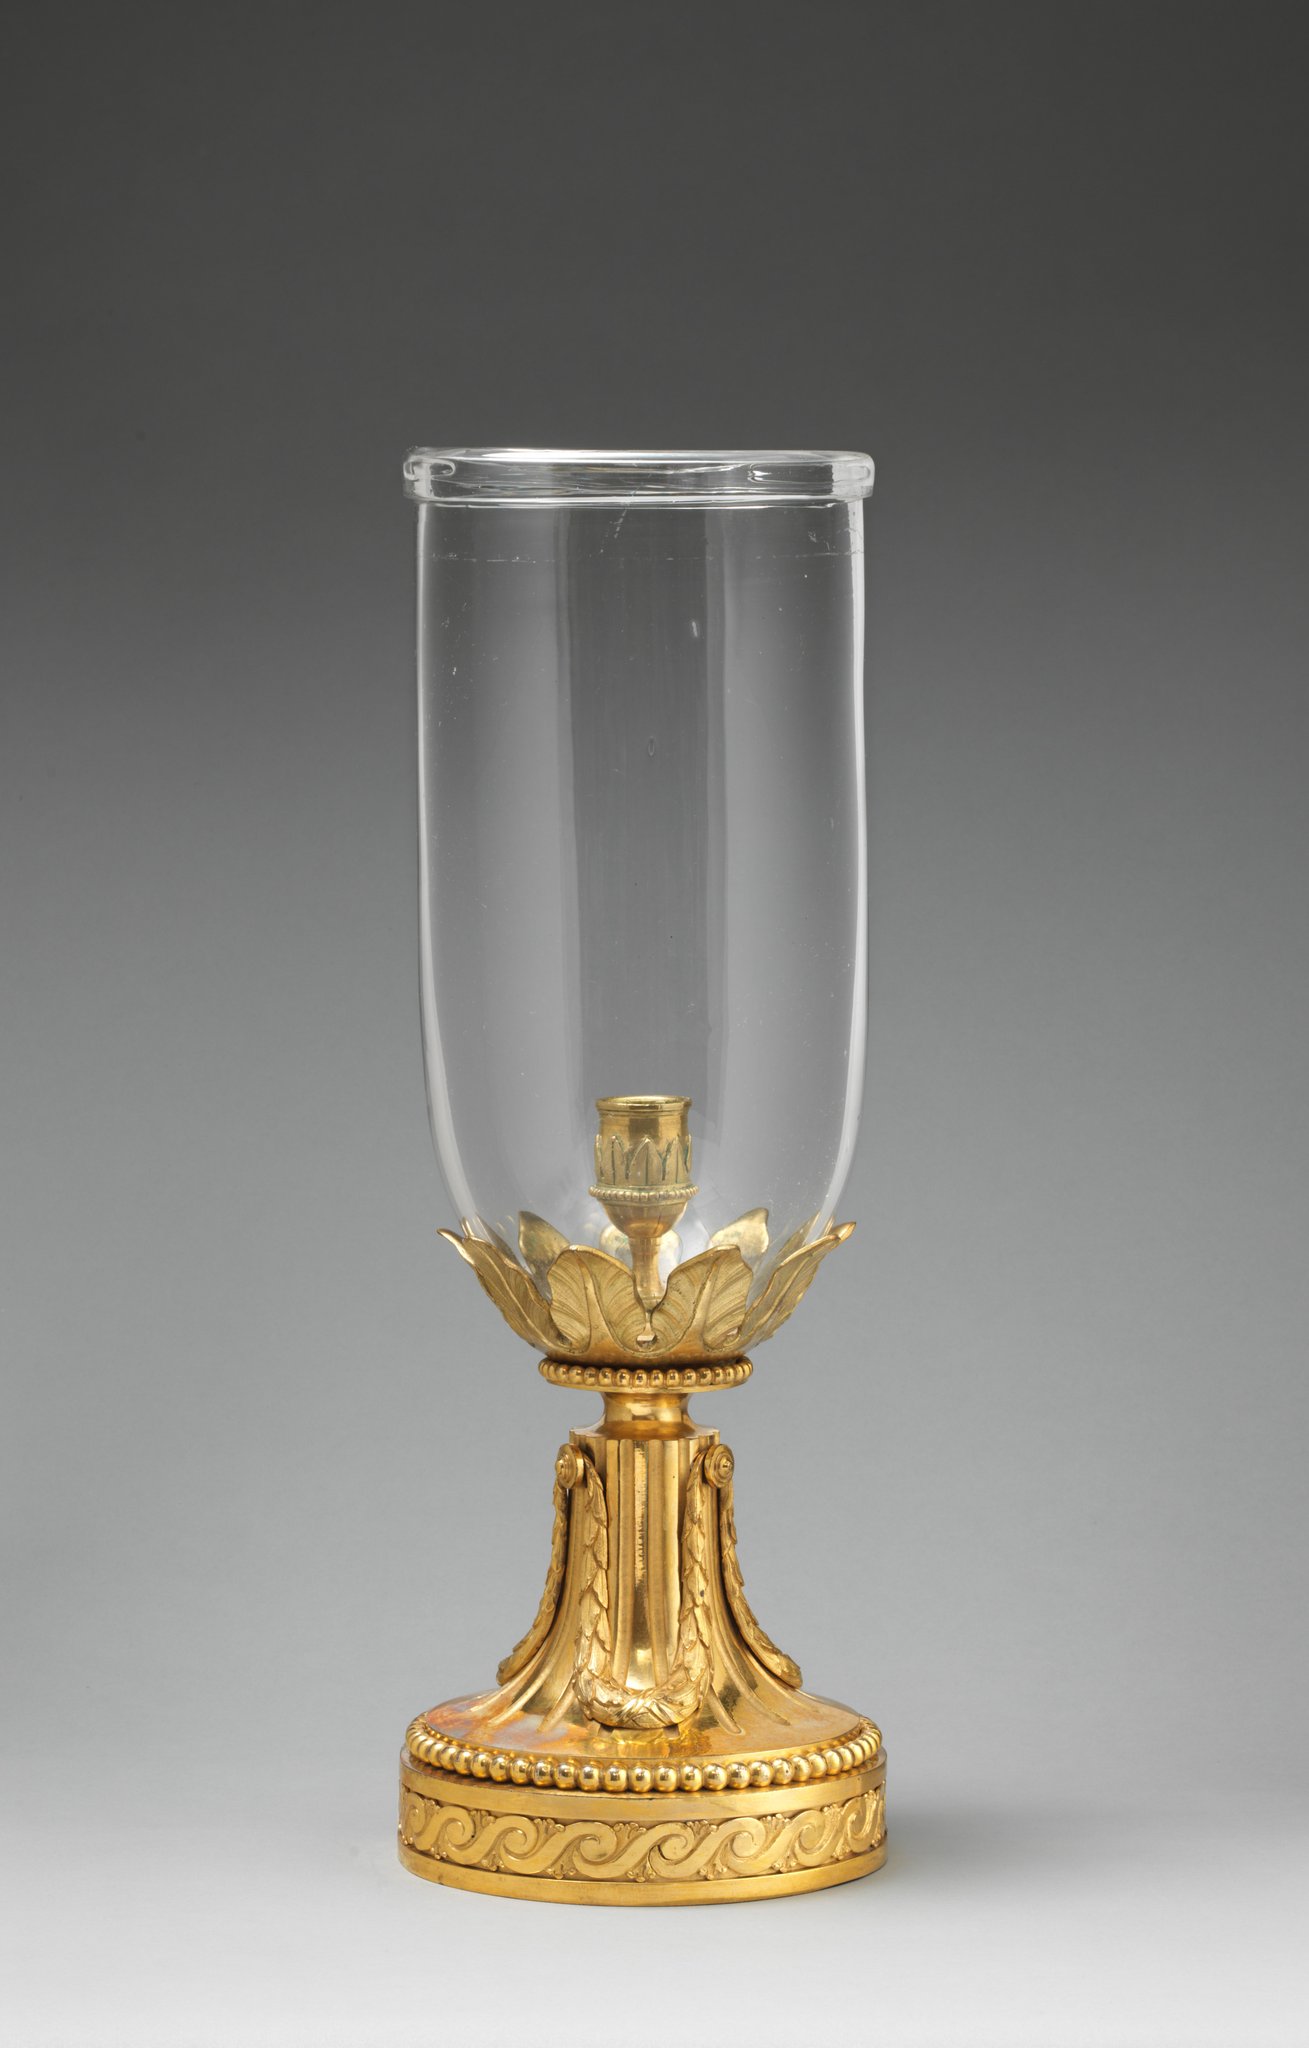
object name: candlestand with shade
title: Candlestand (flambeau de jardin) with shade (one of a pair)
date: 1770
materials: gilt bronze, glass